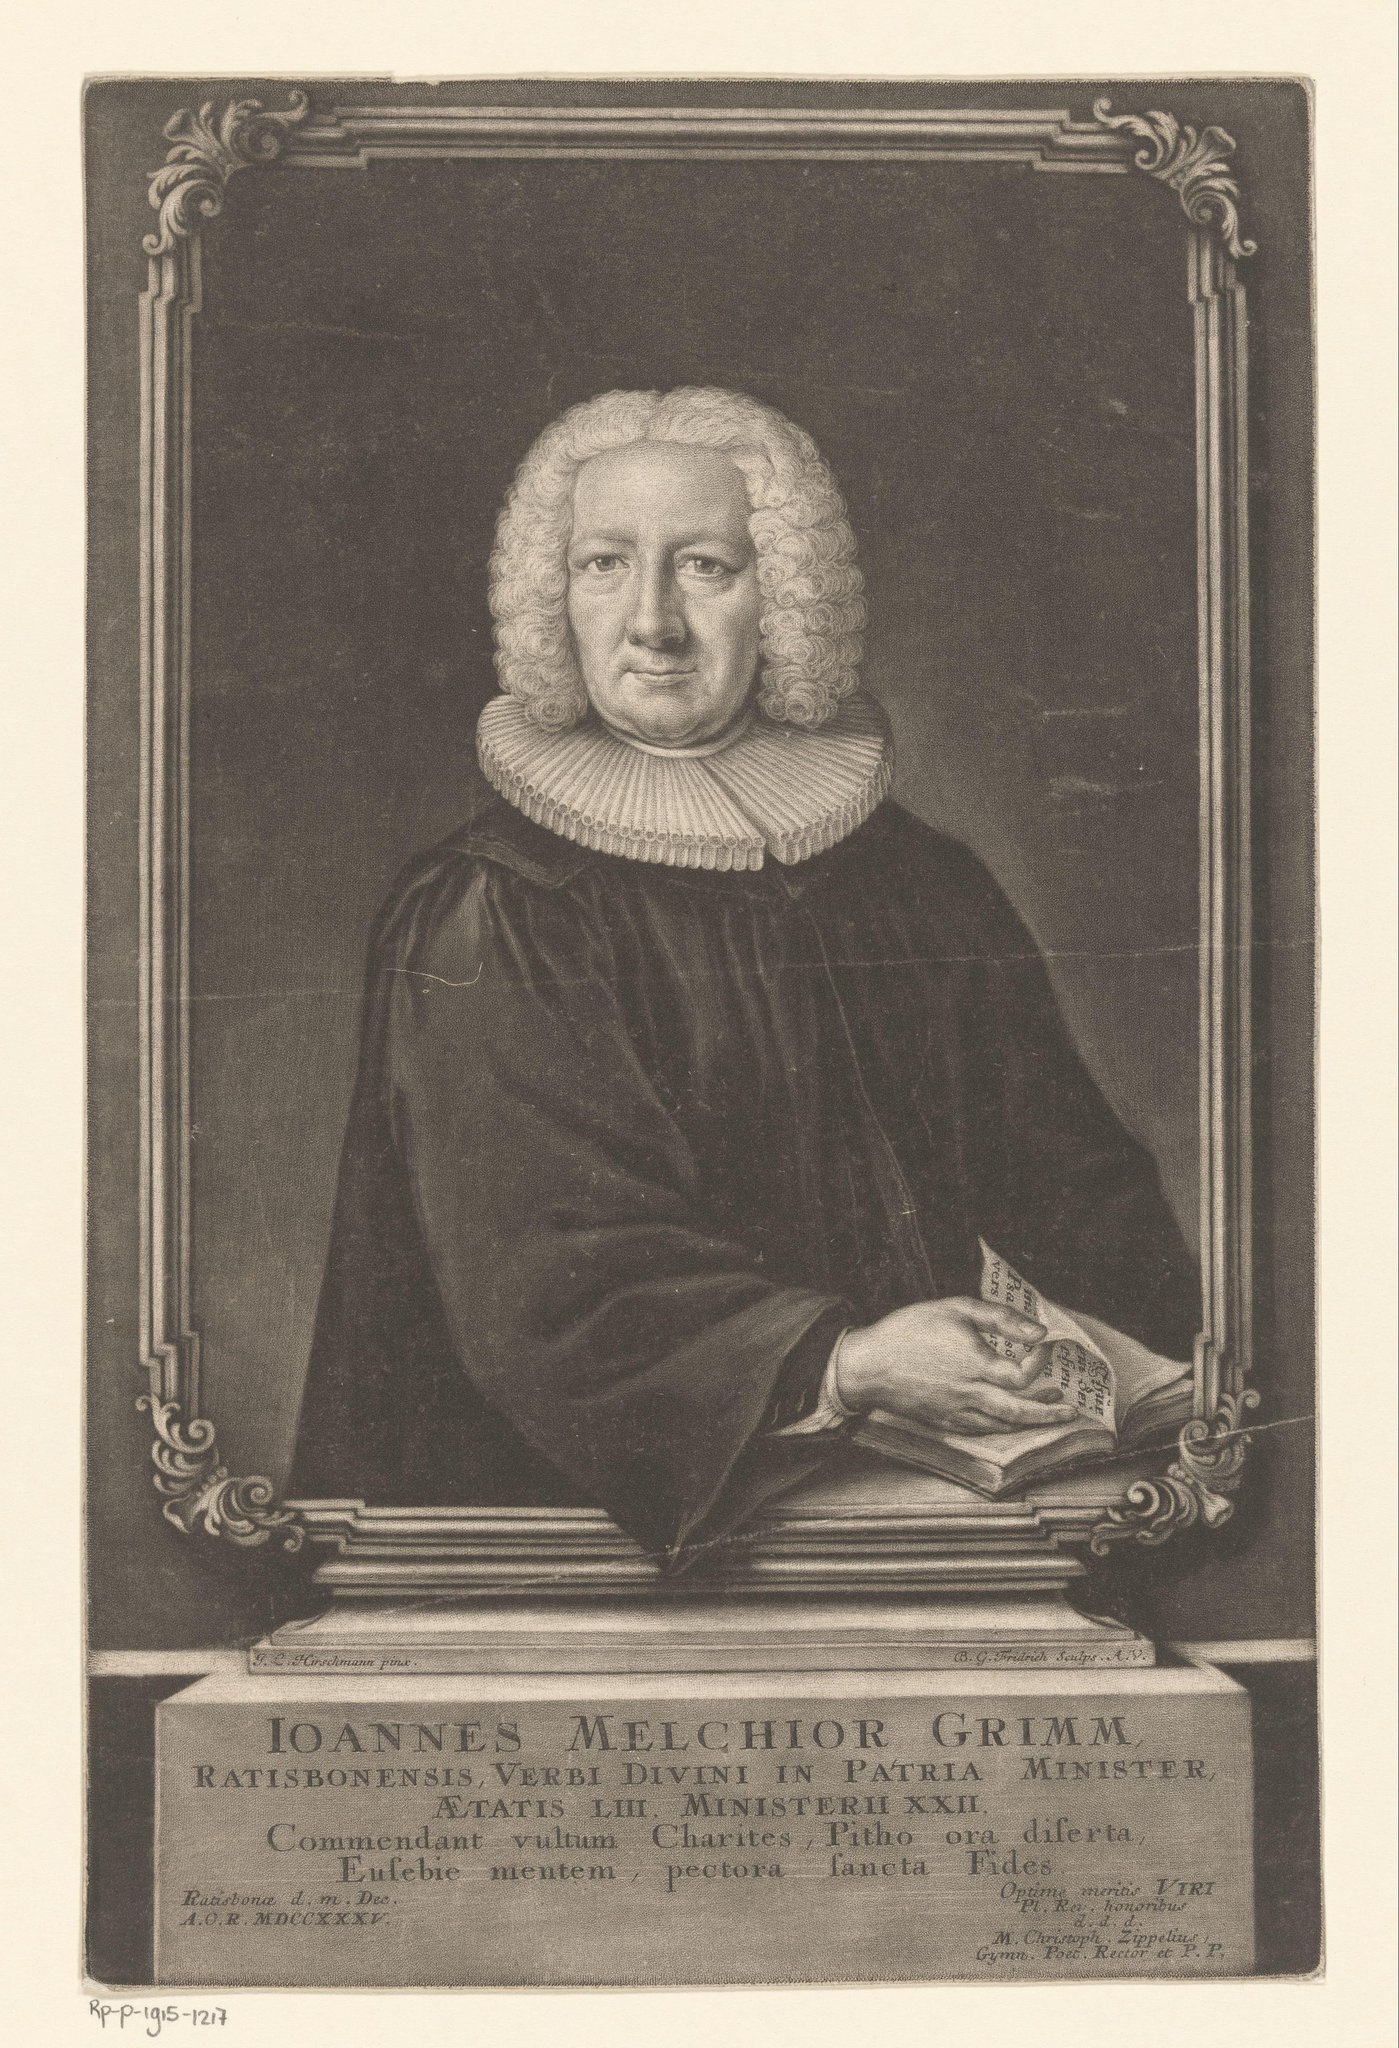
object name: print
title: Portret van Johann Melchior Grimm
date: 1735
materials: paper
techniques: mezzotint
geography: augsburg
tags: historical persons, book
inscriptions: collector's mark: Lugt 2228